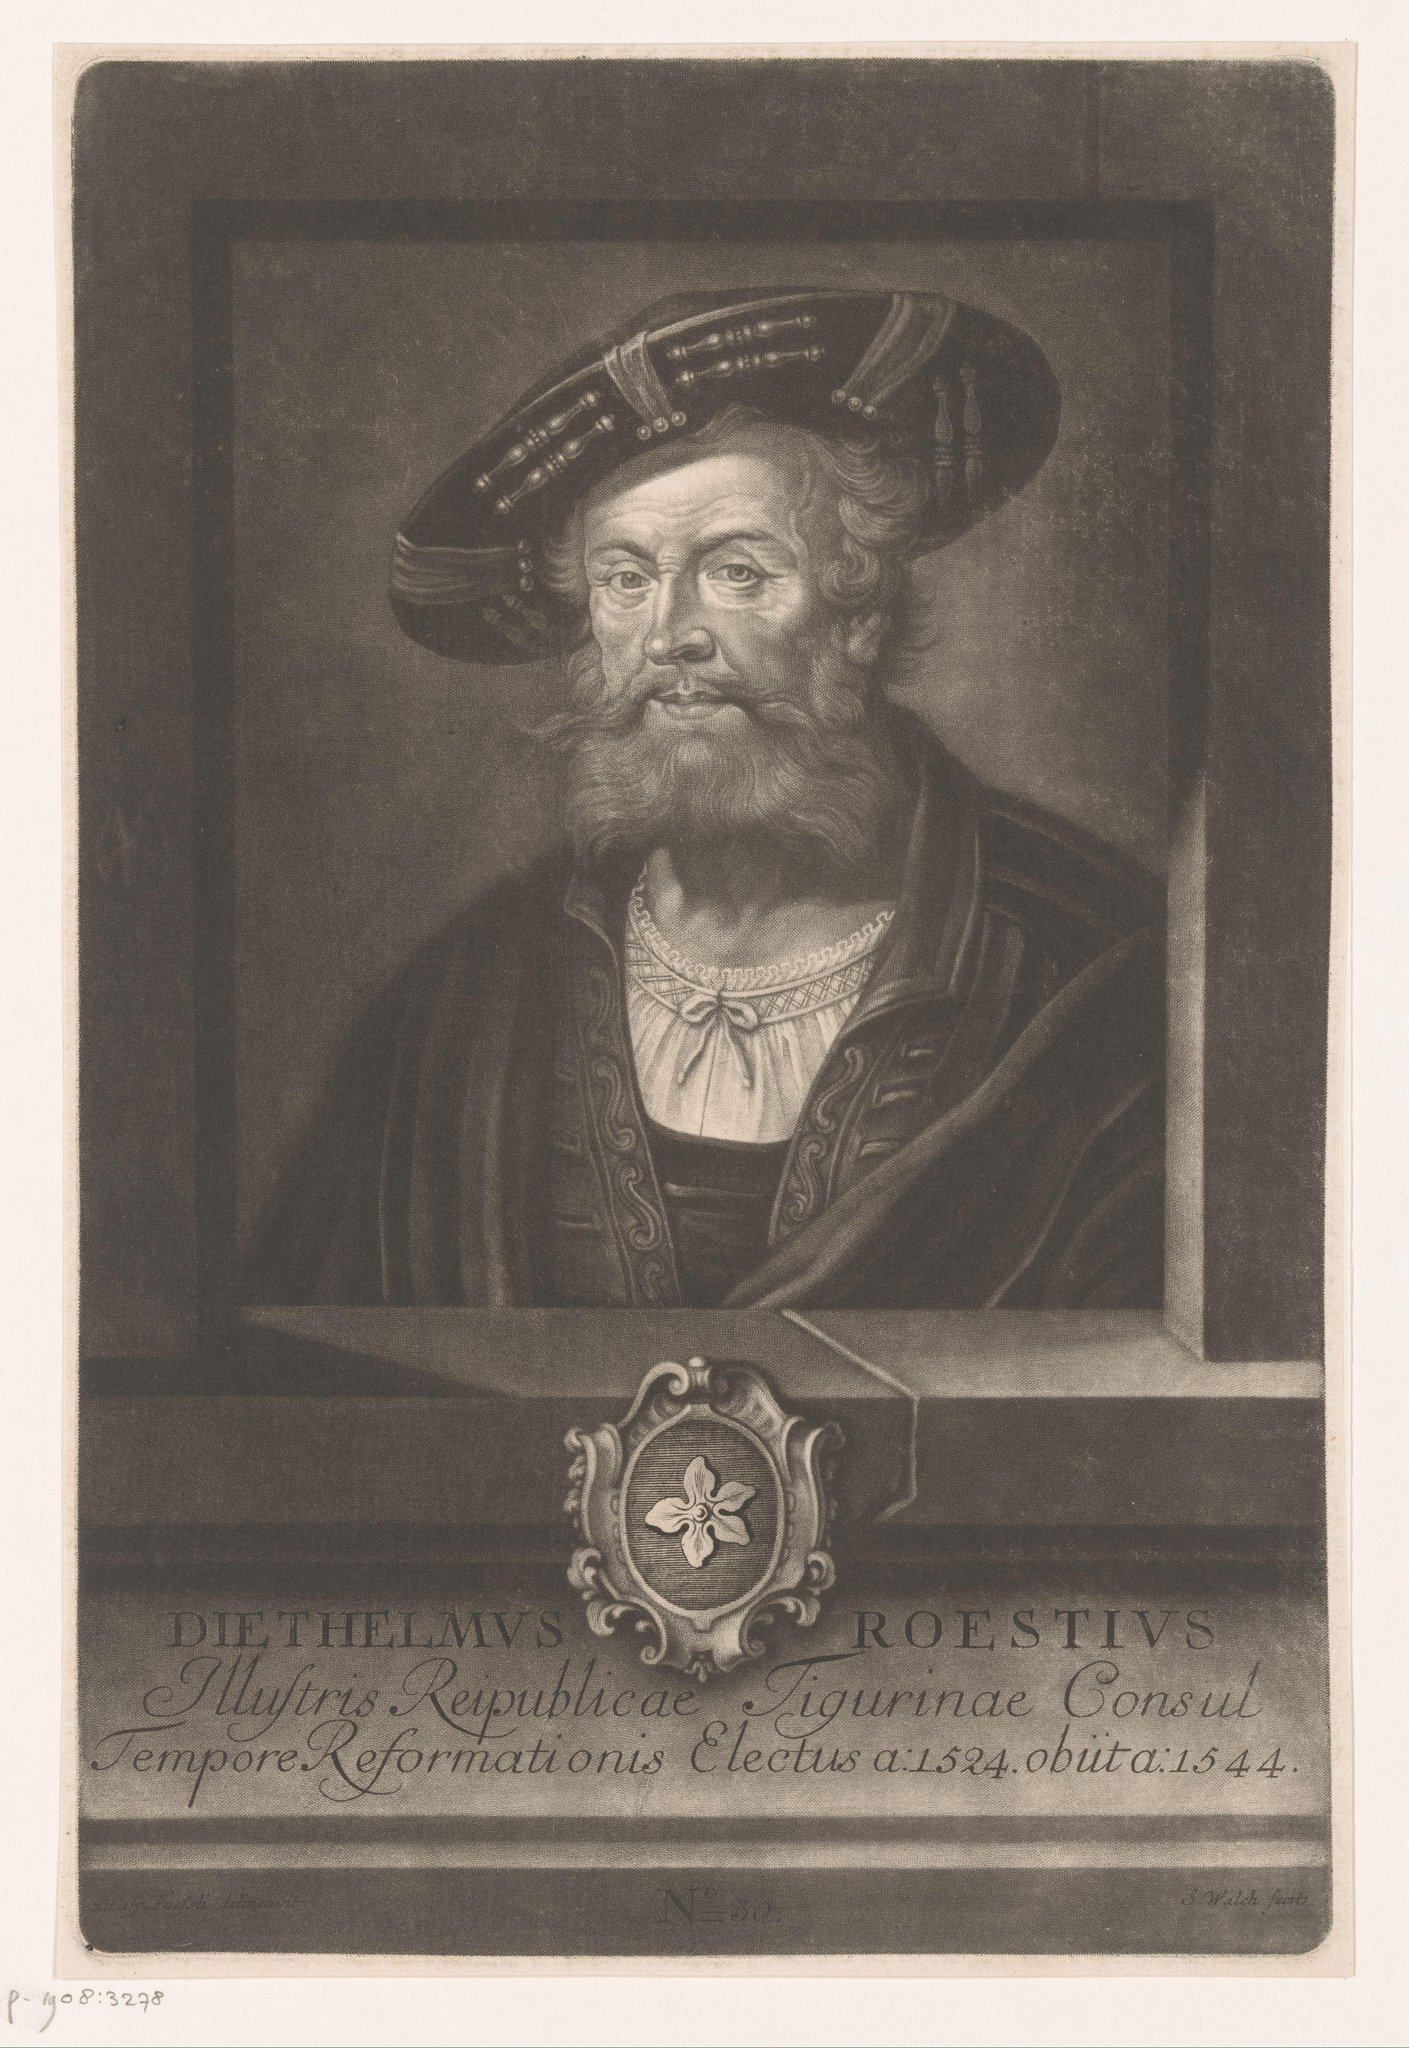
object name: print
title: Portret van Diethelm Röist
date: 1731-1788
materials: paper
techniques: mezzotint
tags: historical persons, armorial bearing, heraldry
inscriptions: collector's mark: Lugt 2228